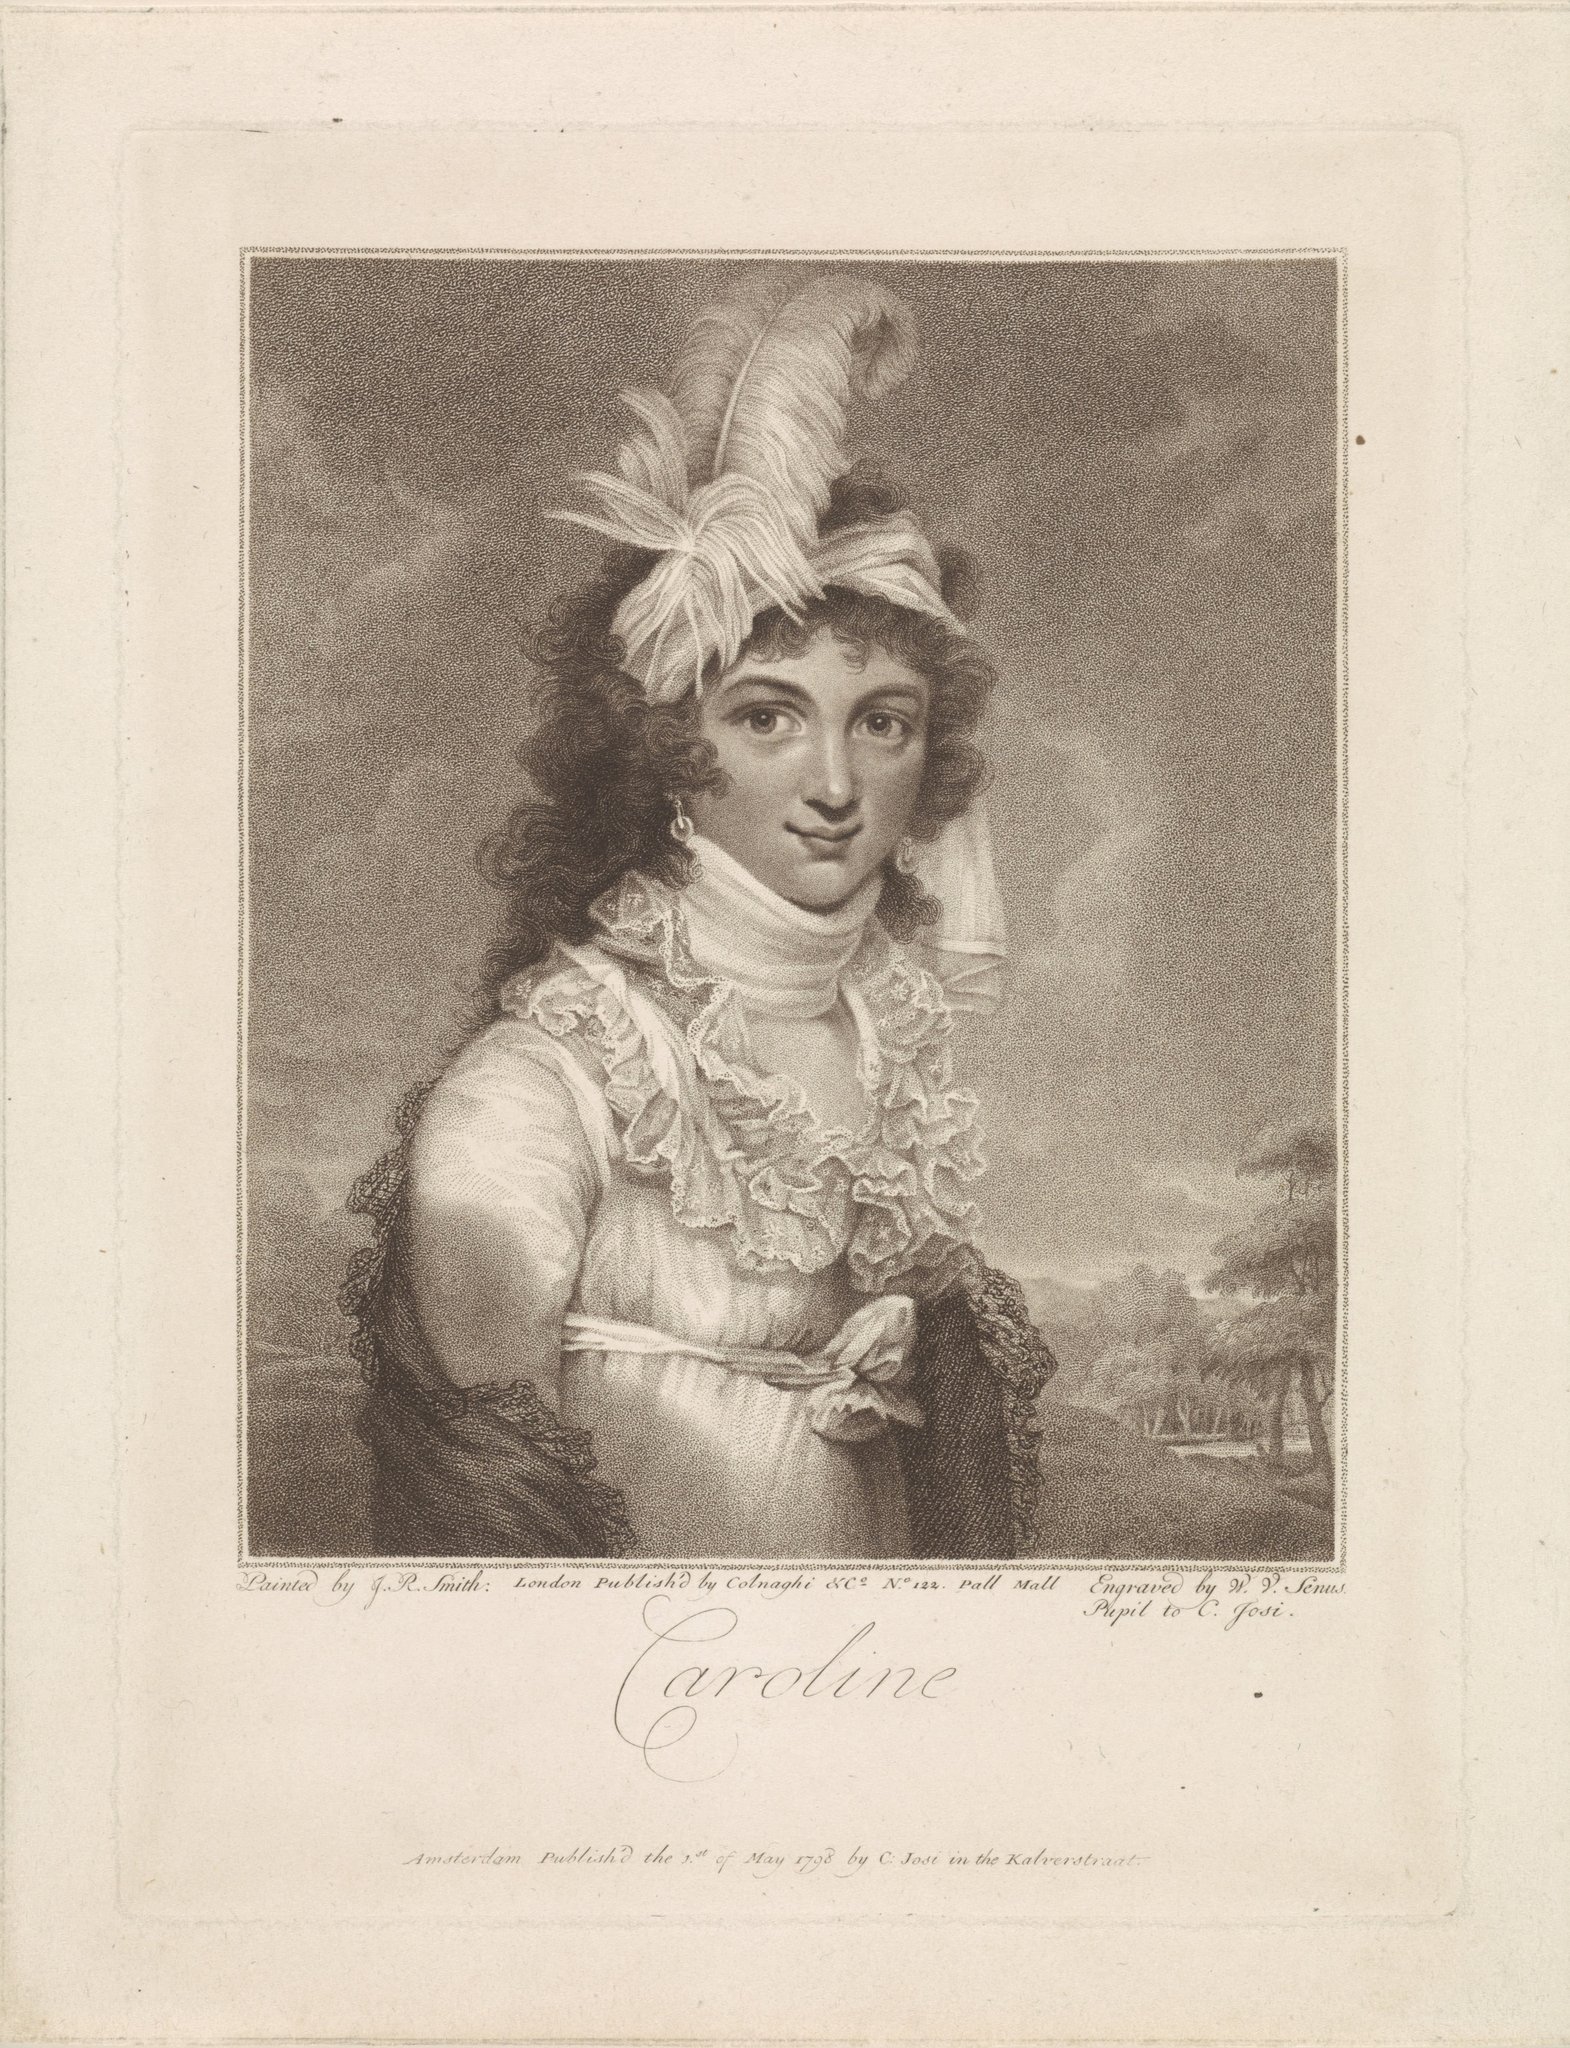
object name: print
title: Portret van Caroline Amalia Elisabeth van Brunswijk-Wolfenbüttel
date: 1798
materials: paper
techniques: etching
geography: amsterdam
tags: london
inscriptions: collector's mark: Lugt 2228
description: Portret van de Engelse prinses Caroline Amalia Elisabeth van Brunswijk-Wolfenbüttel, echtgenote van George, Prins van Wales, de latere koning George IV van het Verenigd Koninkrijk en Hannover.